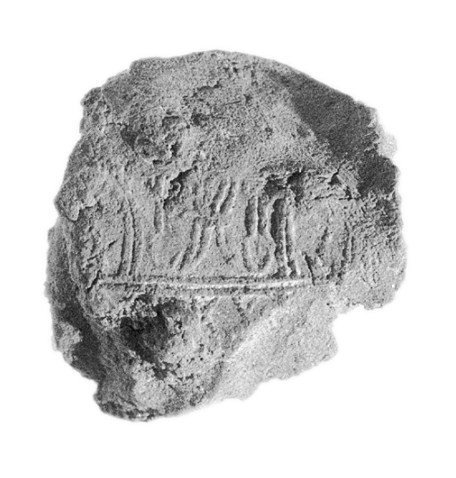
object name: sealing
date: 1981-1640 BCE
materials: mud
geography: egypt